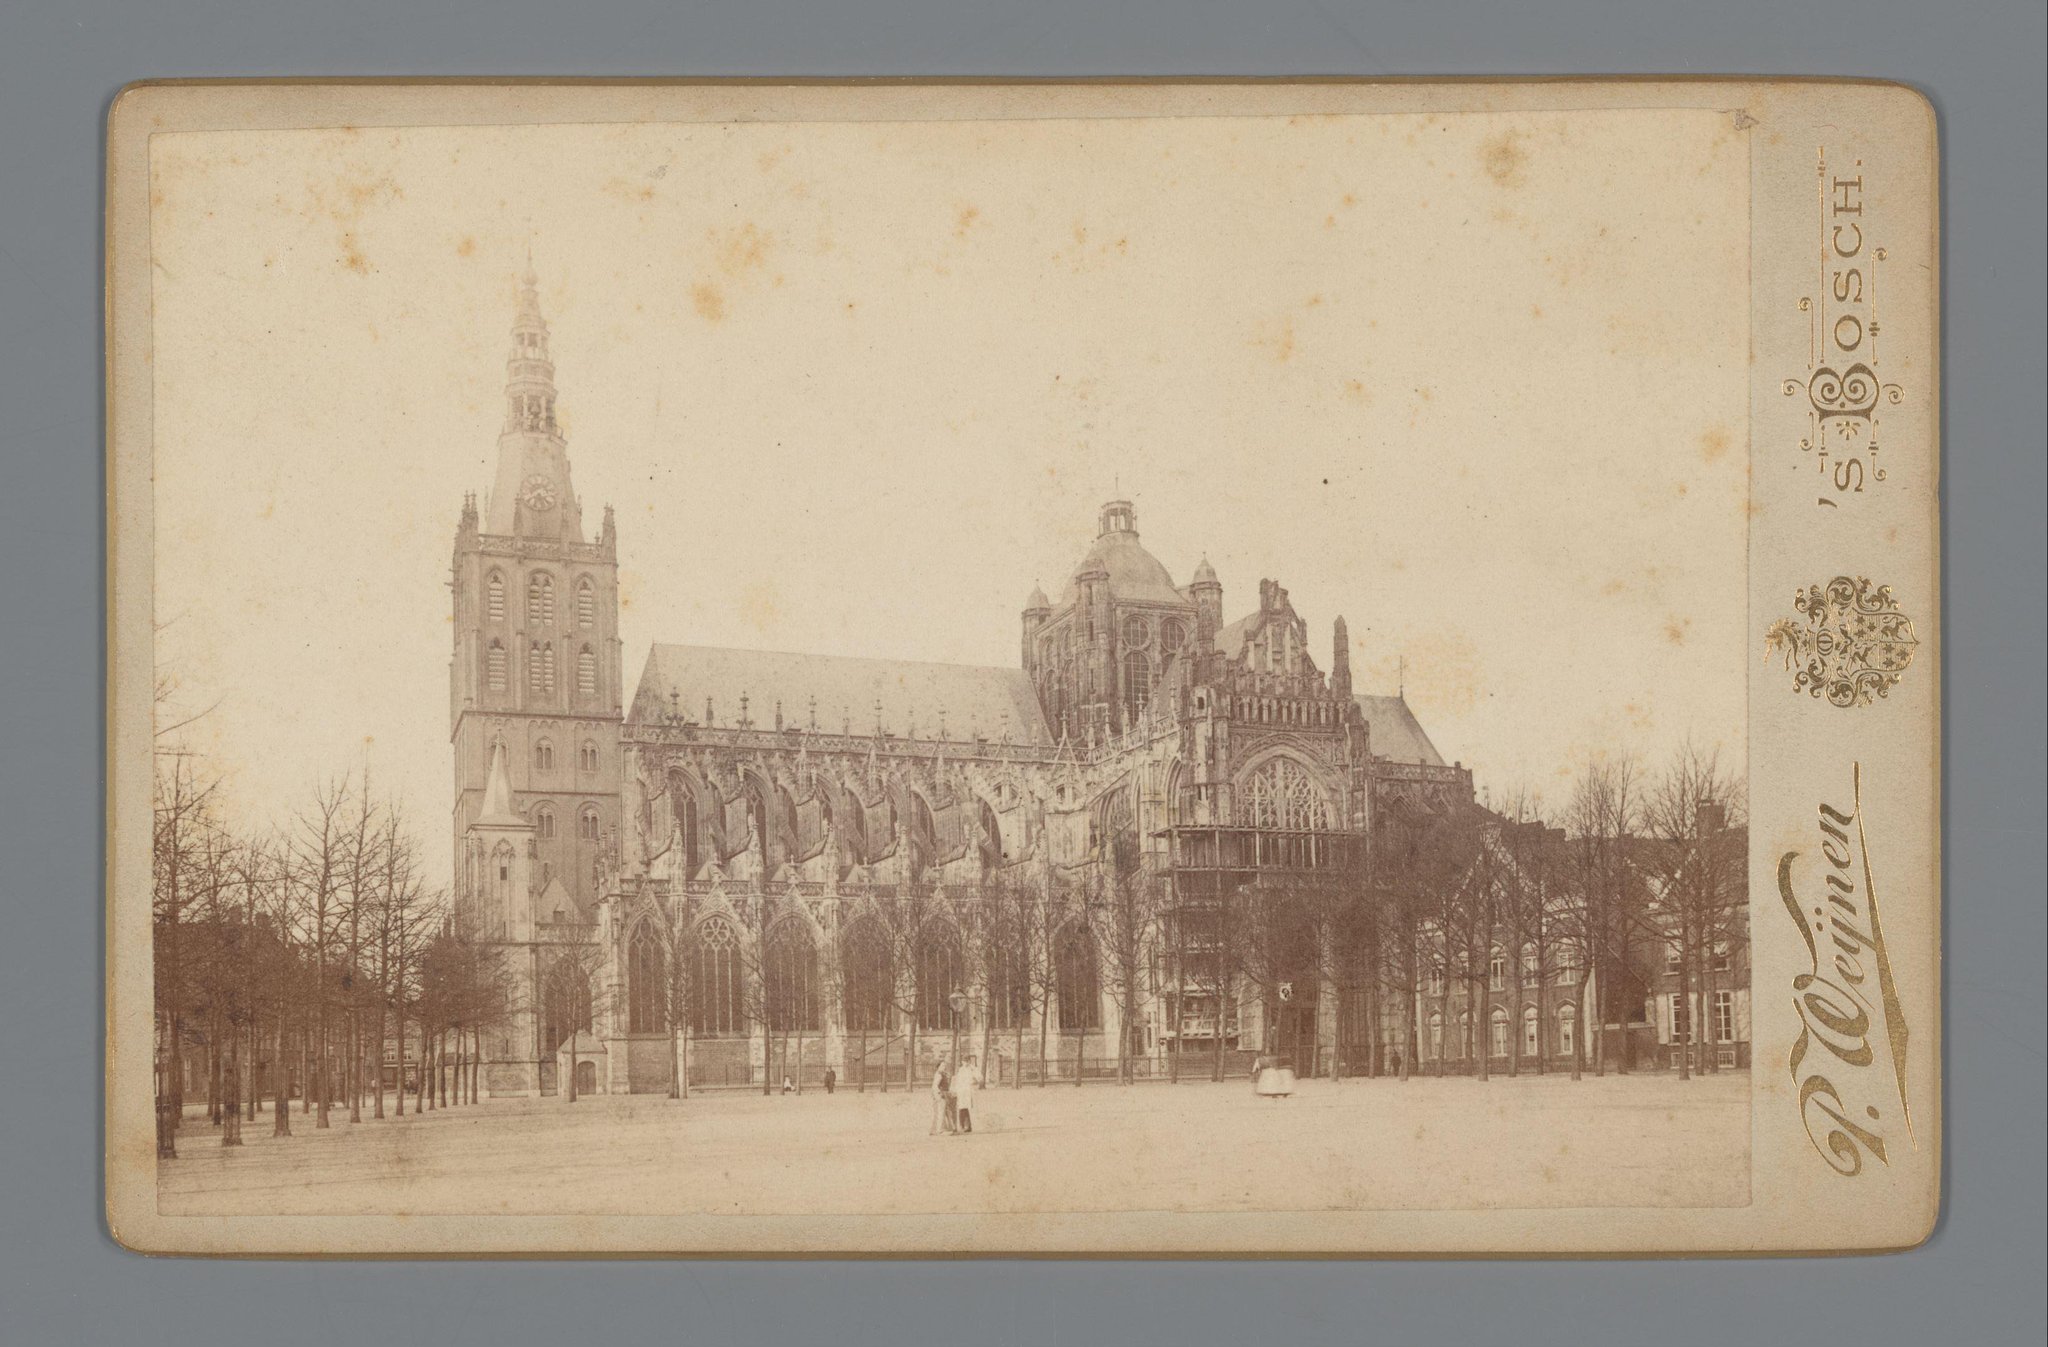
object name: photograph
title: Gezicht op de Sint-Janskathedraal te 's-Hertogenbosch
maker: pierre weijnen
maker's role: fotograaf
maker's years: 1861-1933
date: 1885-1910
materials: cardboard, photographic support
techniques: albumen print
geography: den bosch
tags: church (exterior)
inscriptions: annotation: ‘St. Jan/ Den Bosch’, inscription: ‘Pierre Weijnen/ 's Bosch’